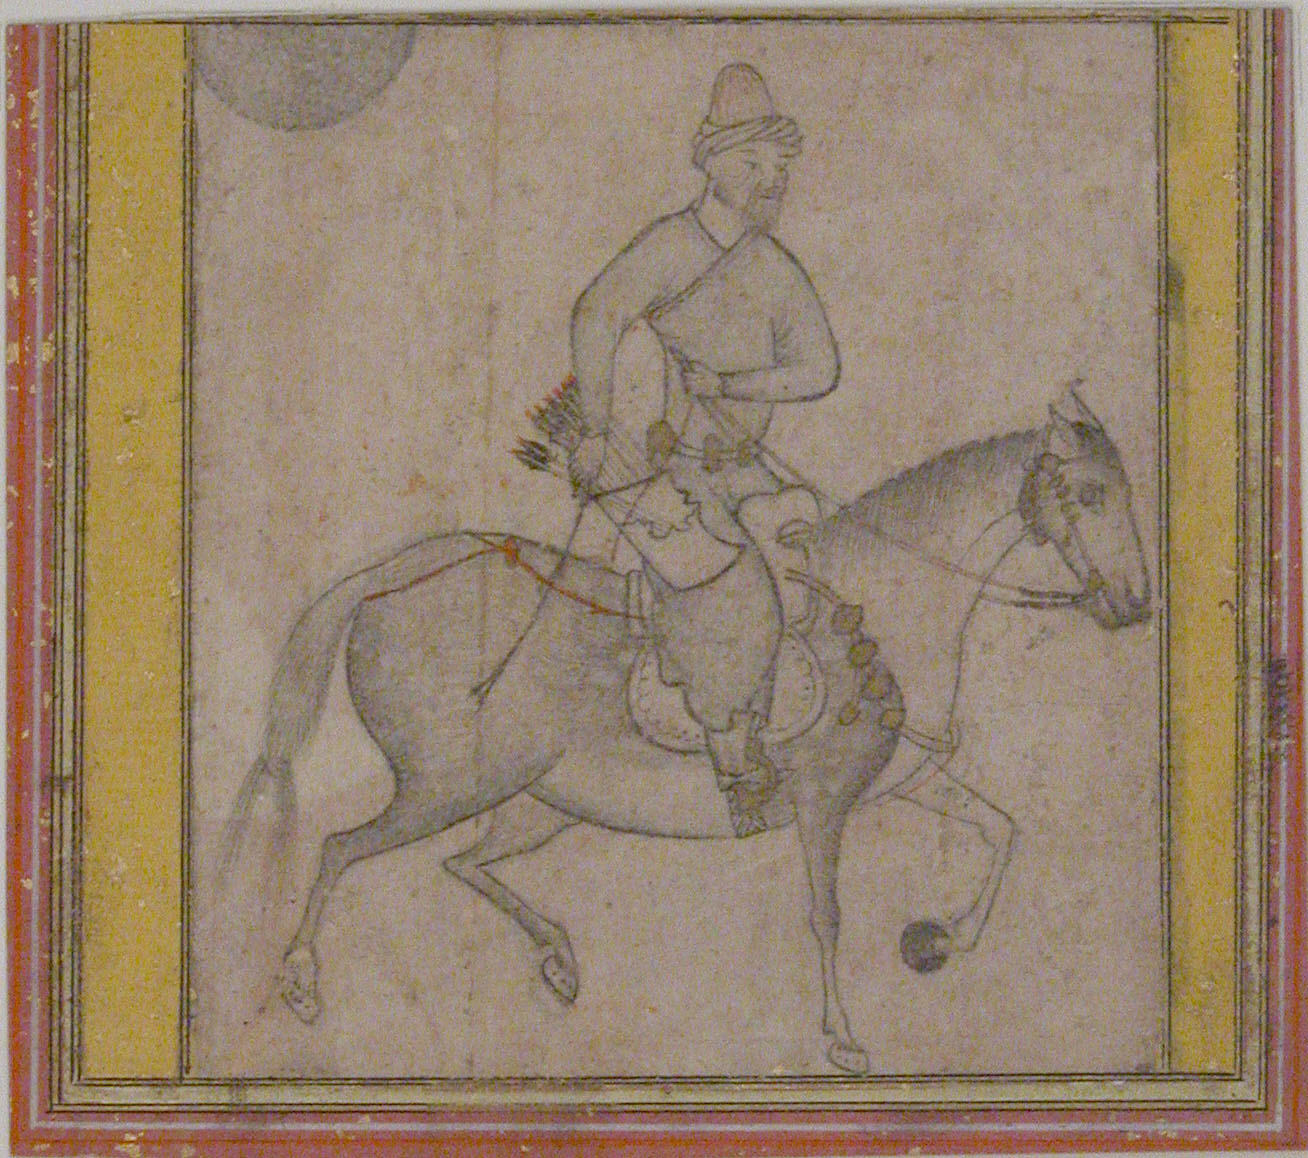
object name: illustrated single work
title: Turkomen Horseman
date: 1501-1600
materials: gold, ink, paper, watercolor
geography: iran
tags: arrows,men,horses